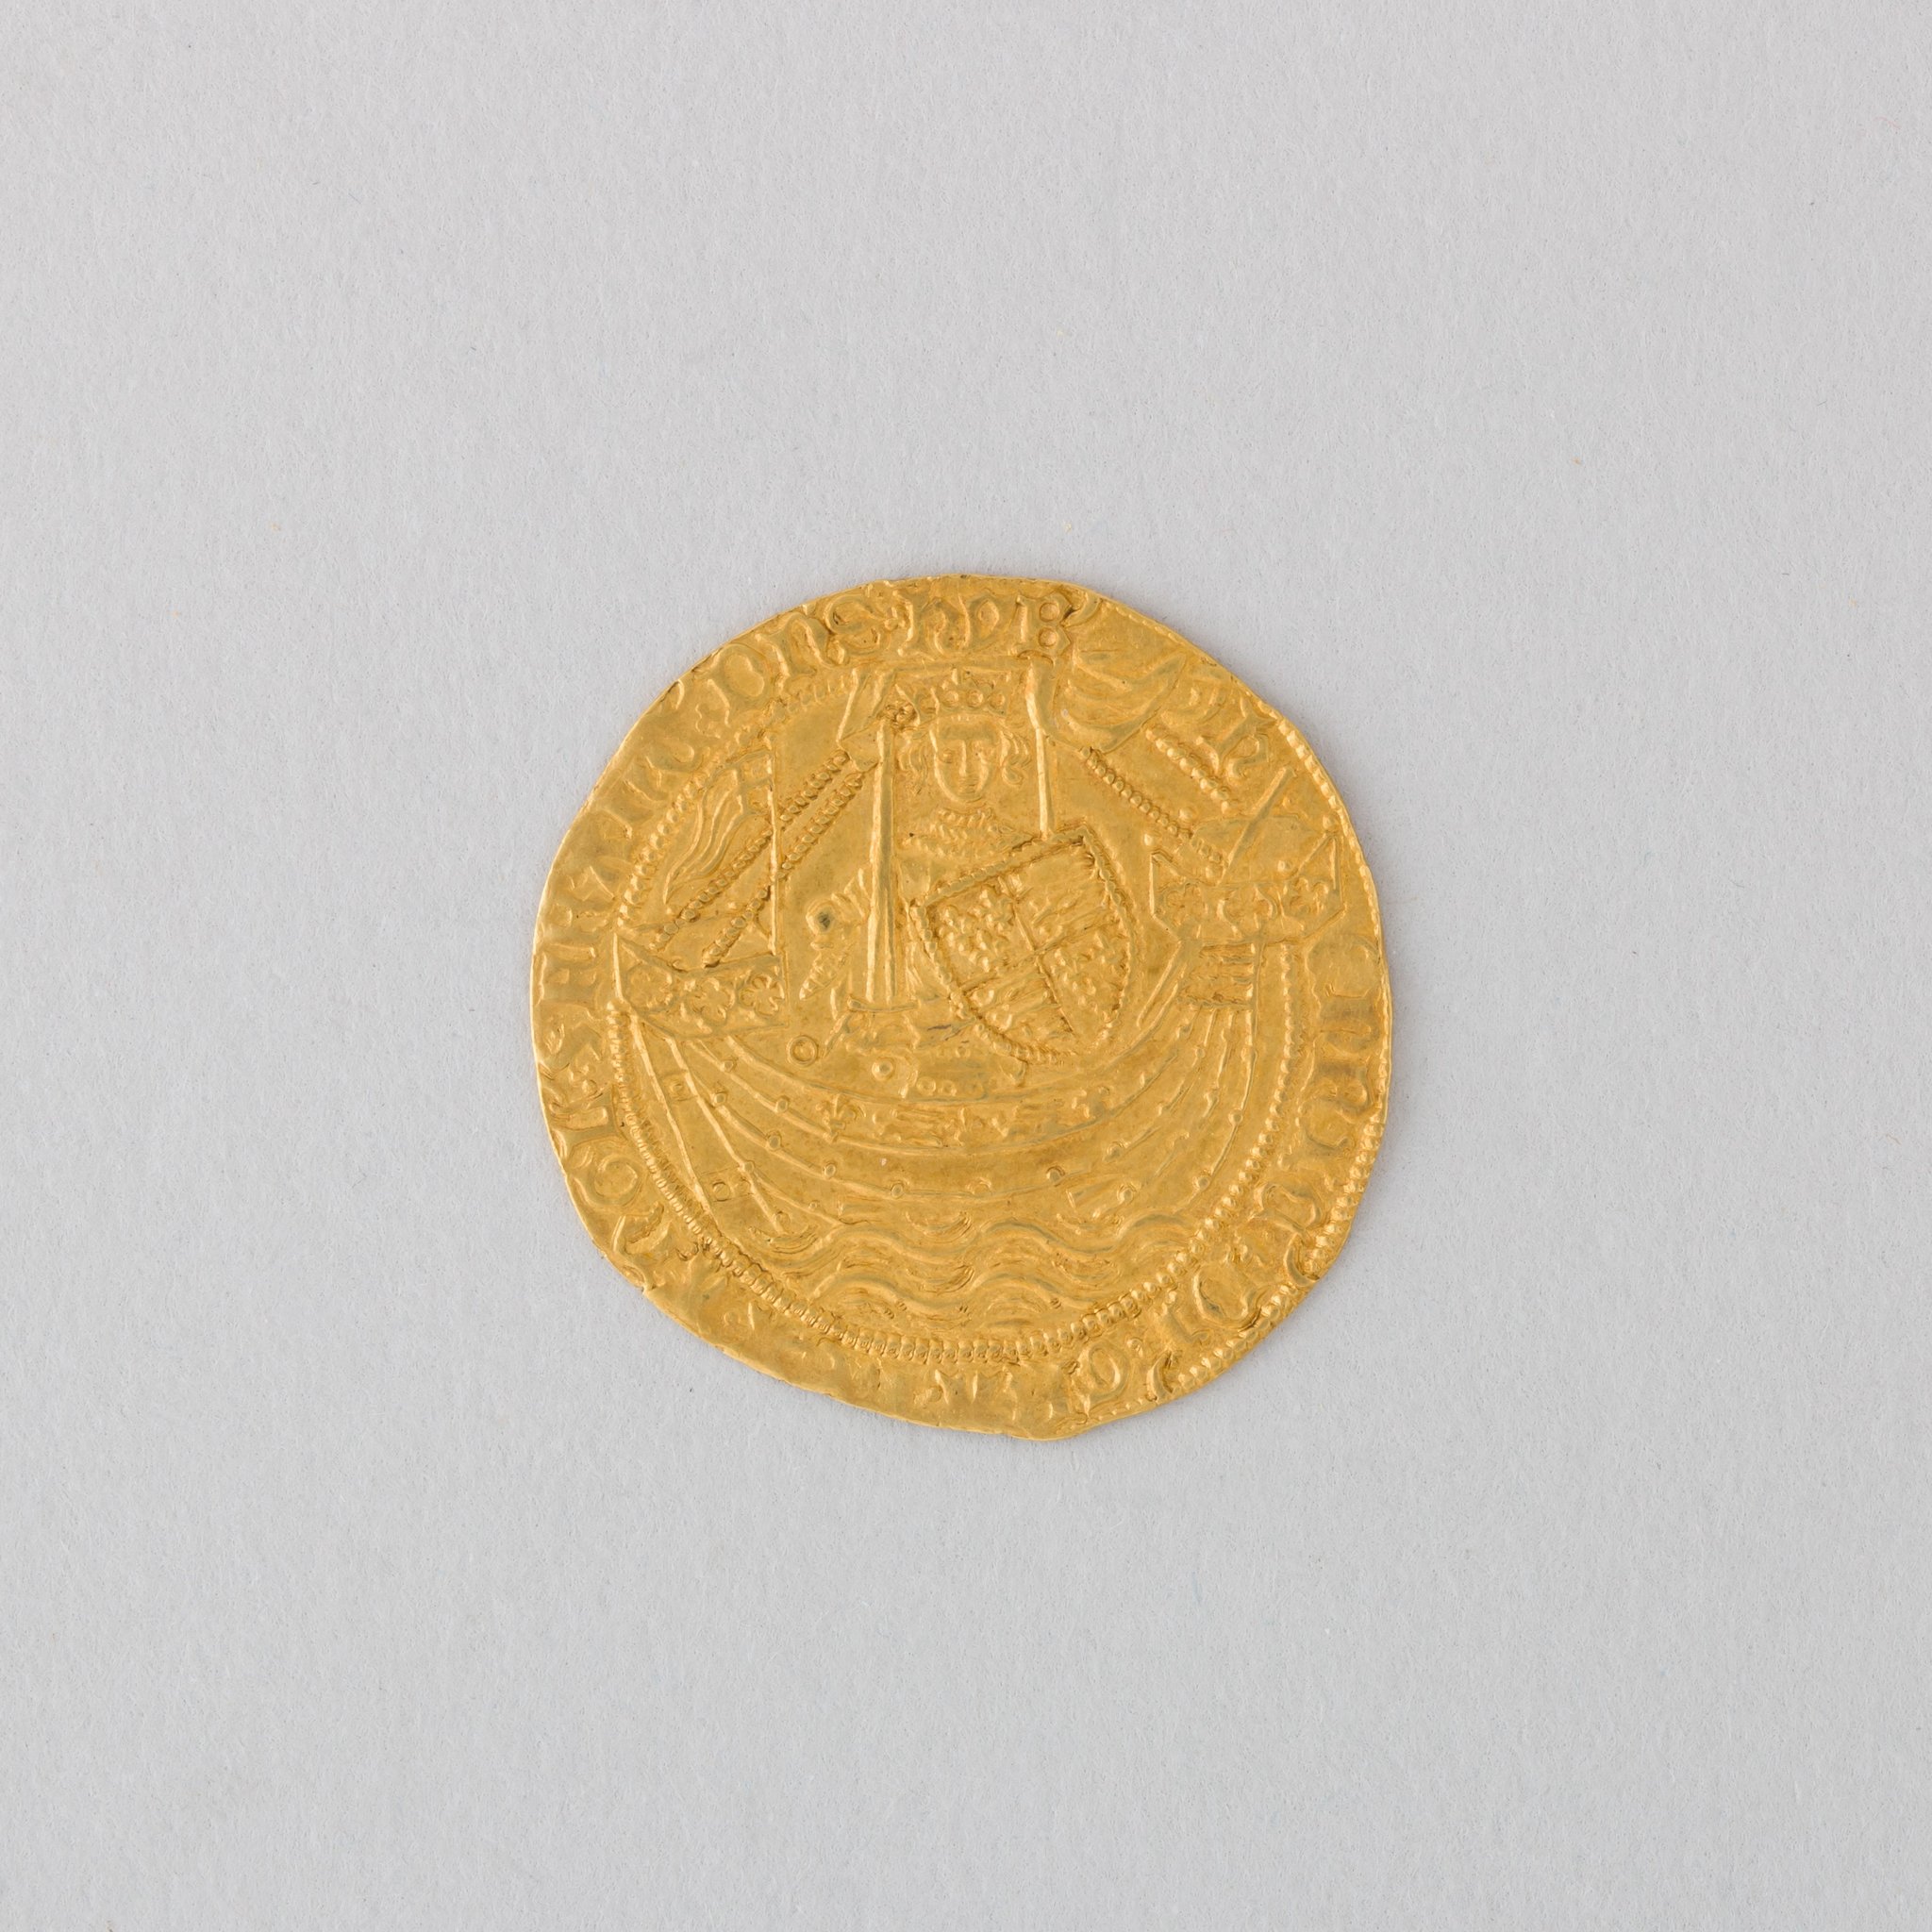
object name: coin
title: Coin (Noble) Showing Henry VI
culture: british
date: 1422-1461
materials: gold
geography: england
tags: coins